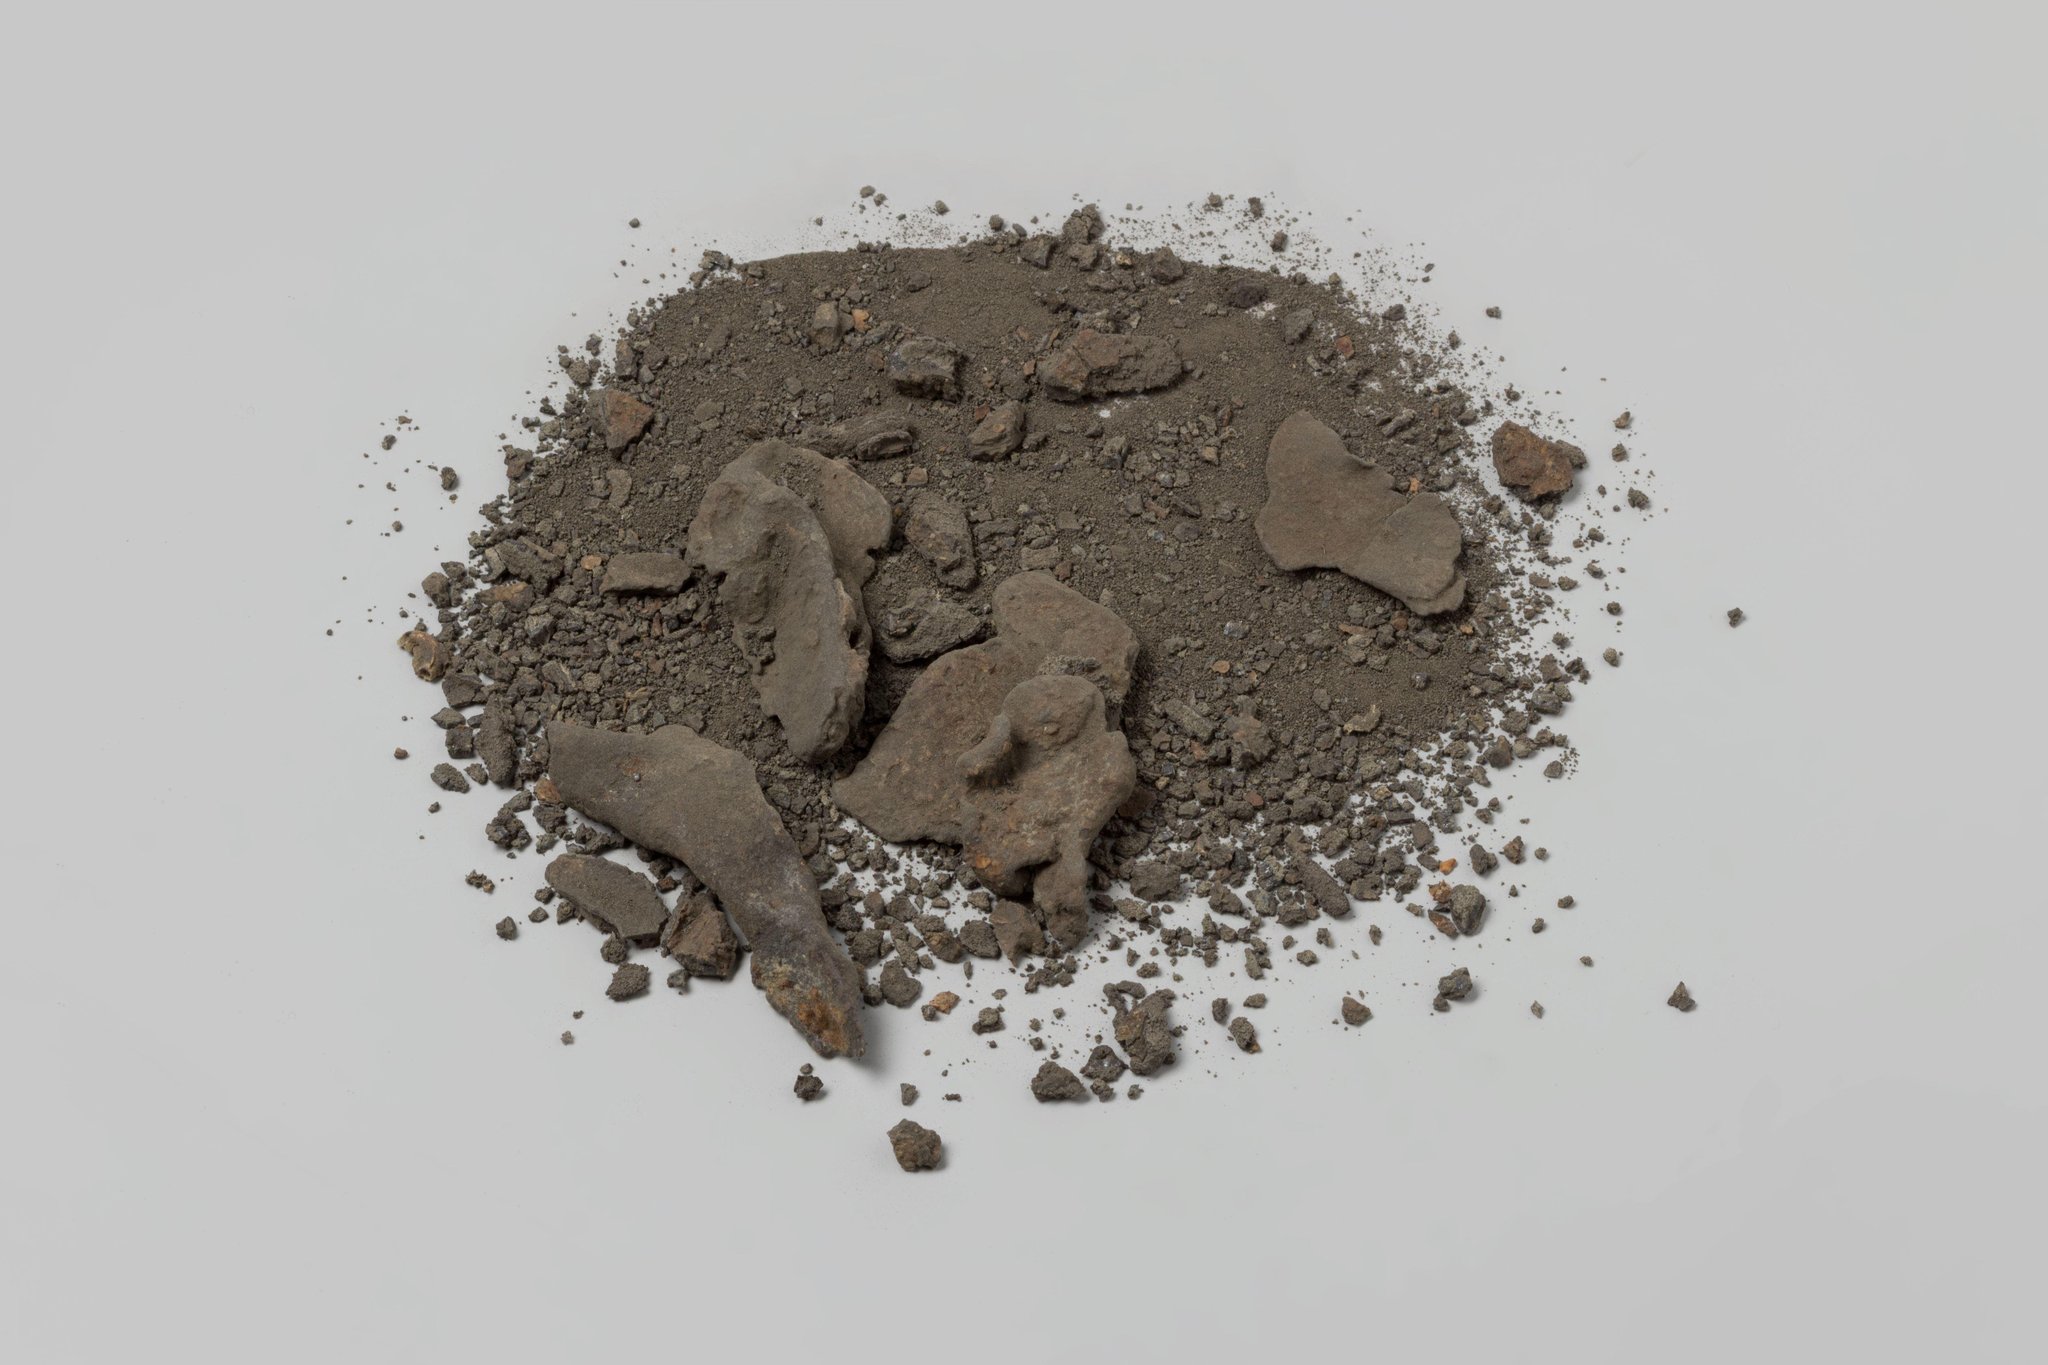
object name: fragment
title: Fragmenten en gruis van tin uit het wrak van de Oost-Indiëvaarder Hollandia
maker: Anonymous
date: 1700-1743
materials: tin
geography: netherlands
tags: verenigde oostindische compagnie, hollandia (schip), annet